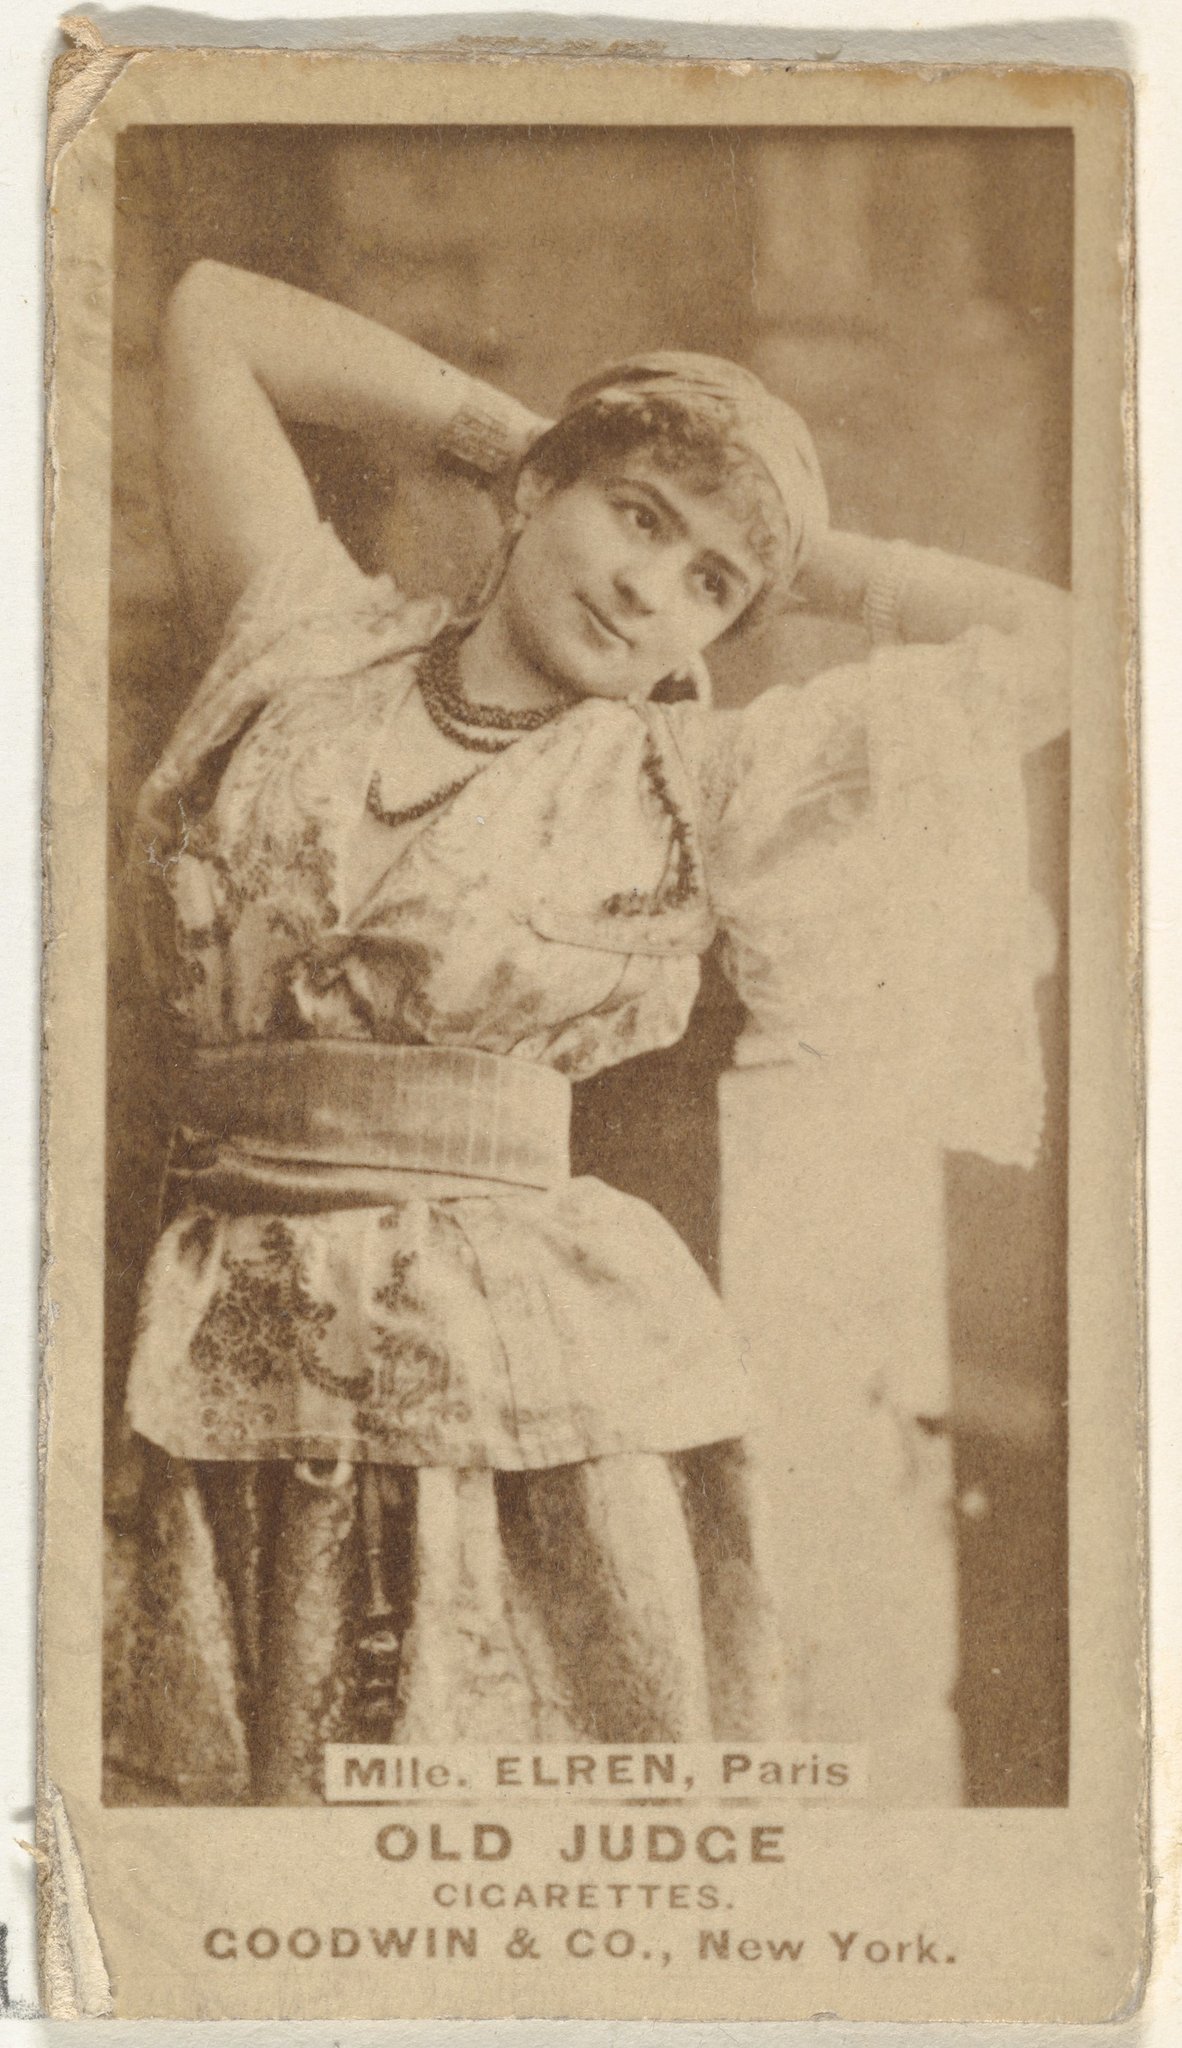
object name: photograph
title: Mlle. Elren, Paris, from the Actors and Actresses series (N171) for Old Judge Cigarettes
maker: goodwin & company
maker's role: publisher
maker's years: 1850-1950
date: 1886-1890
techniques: albumen silver print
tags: portraits,women,actresses